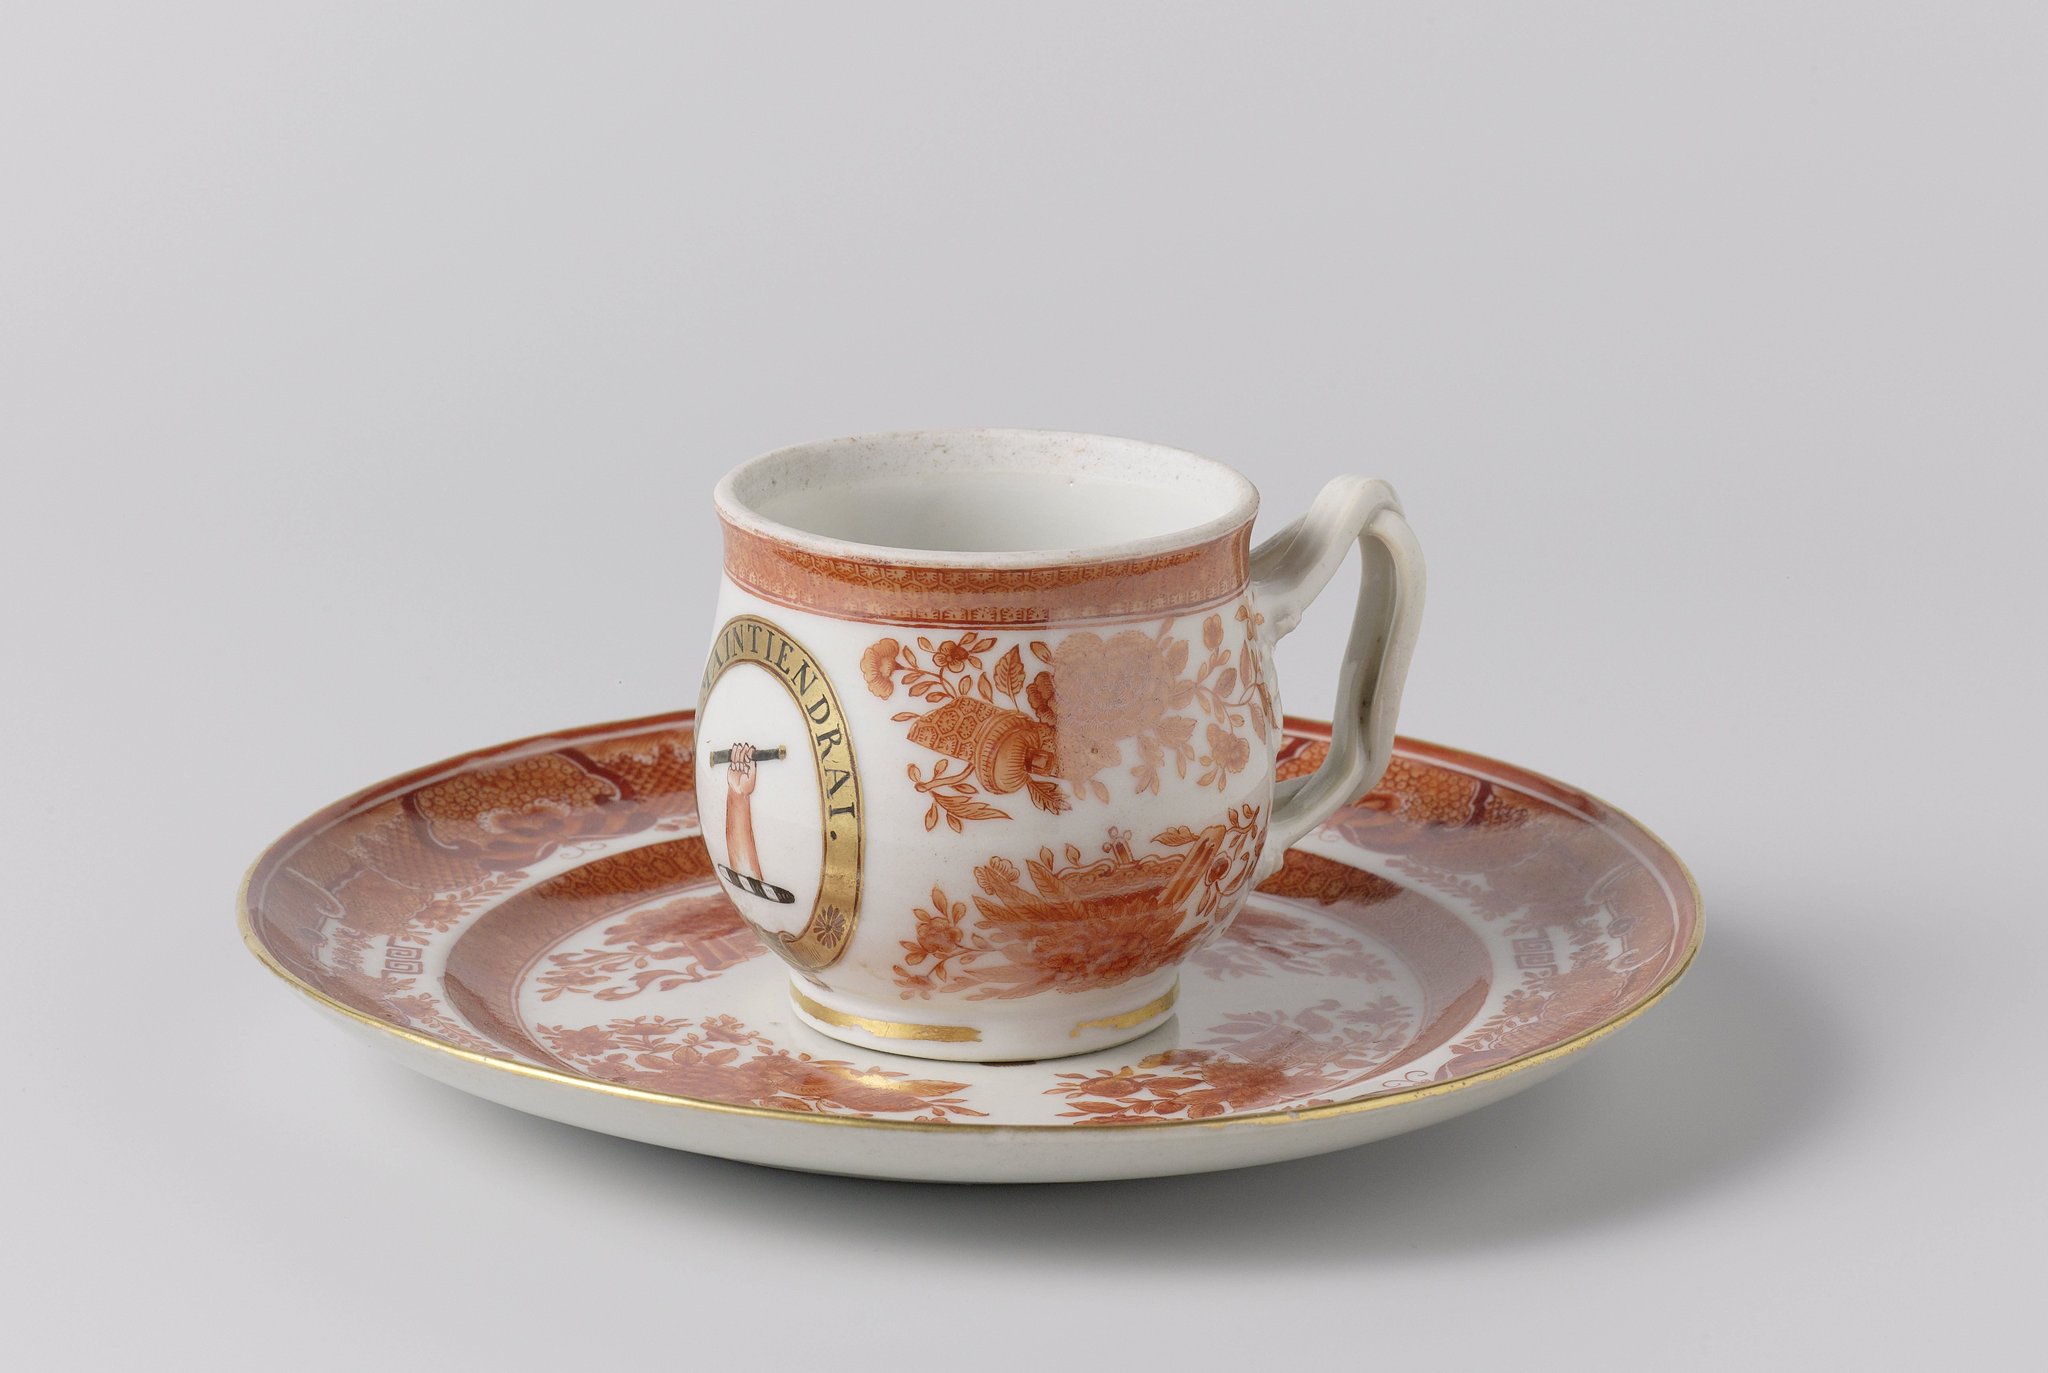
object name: platter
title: Covered cup with a coat of arms, flower sprays and auspicous symbols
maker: Anonymous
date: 1775-1799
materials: glaze, gold, paint, porcelain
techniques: firing, gilding, turning, vitrification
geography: china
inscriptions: inscription: ‘JE LE MAINTIENDRAI’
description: Schotel van porselein, beschilderd op het glazuur in rood, zwart en goud. Op het plat een ongeïdentificeerd familiewapen met een hand die een staf vasthoudt tegen een witte achtergrond; om het wapen het opschrift 'JE LE MAINTIENDRAI'. Om het wapen bloemtakken met gelukssymbolen. Op de wand een band met servetwerk. De rand met een decoratieve band met servetwerk in cartouches, bloemtakken en vlinders. Oud label op de onderzijde met 'Nesbit zou zijn: / 3x boar en een rode keper/ Crisp Oct: 1912'. Wapenporselein met emailkleuren.